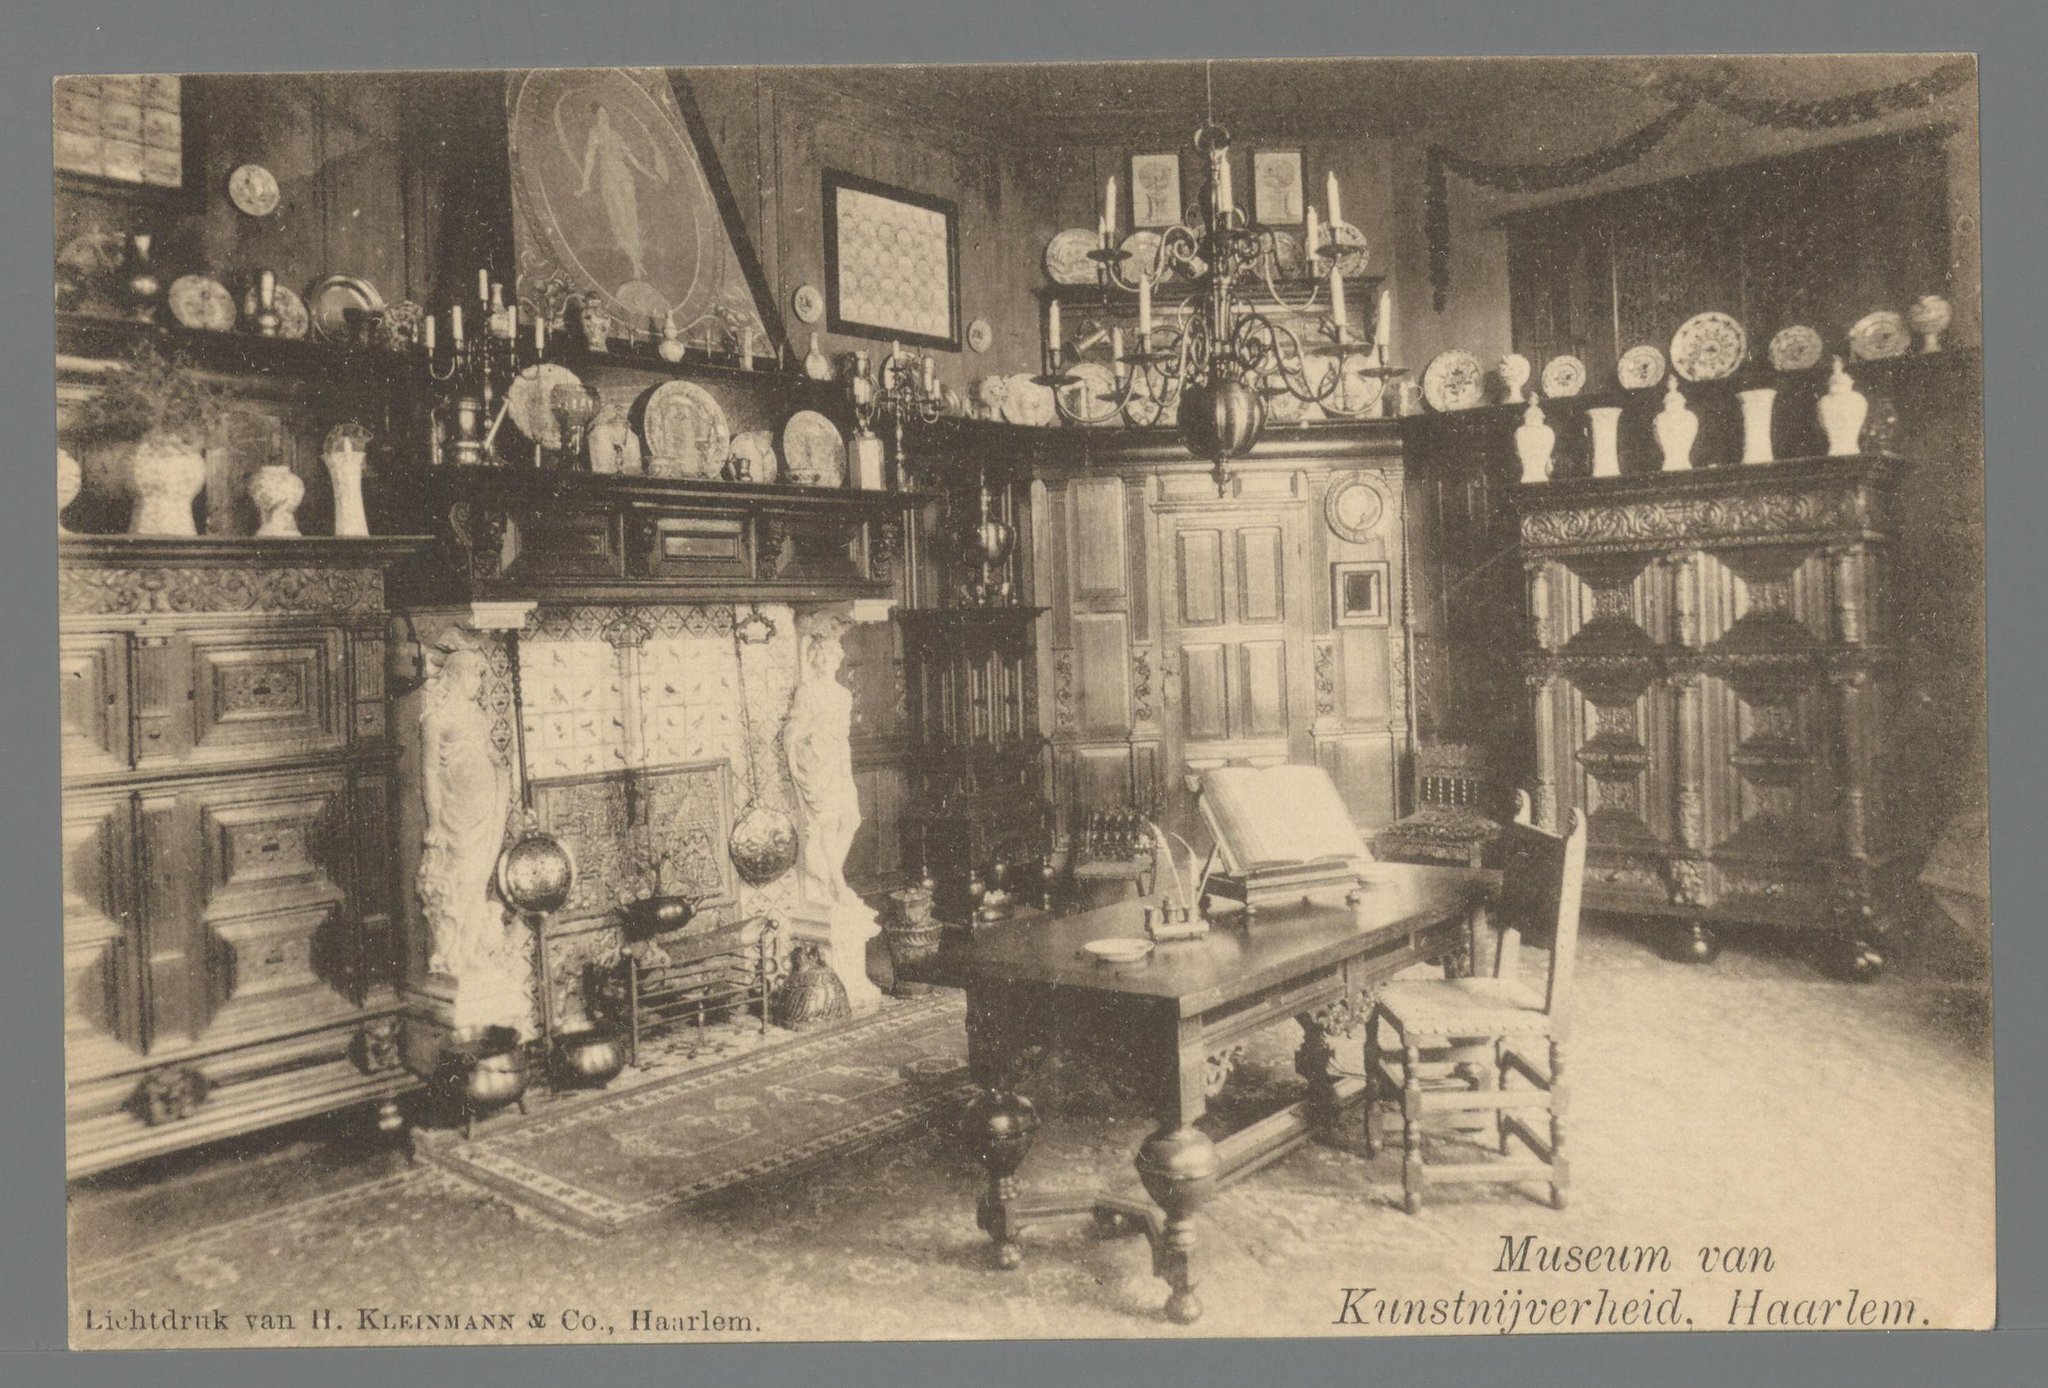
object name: ansichtkaart, prentbriefkaart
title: Museum van Kunstnijverheid, Haarlem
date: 1894-1905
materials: cardboard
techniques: photograph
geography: haarlem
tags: interior of the house, permanent exhibition, museum, haarlem